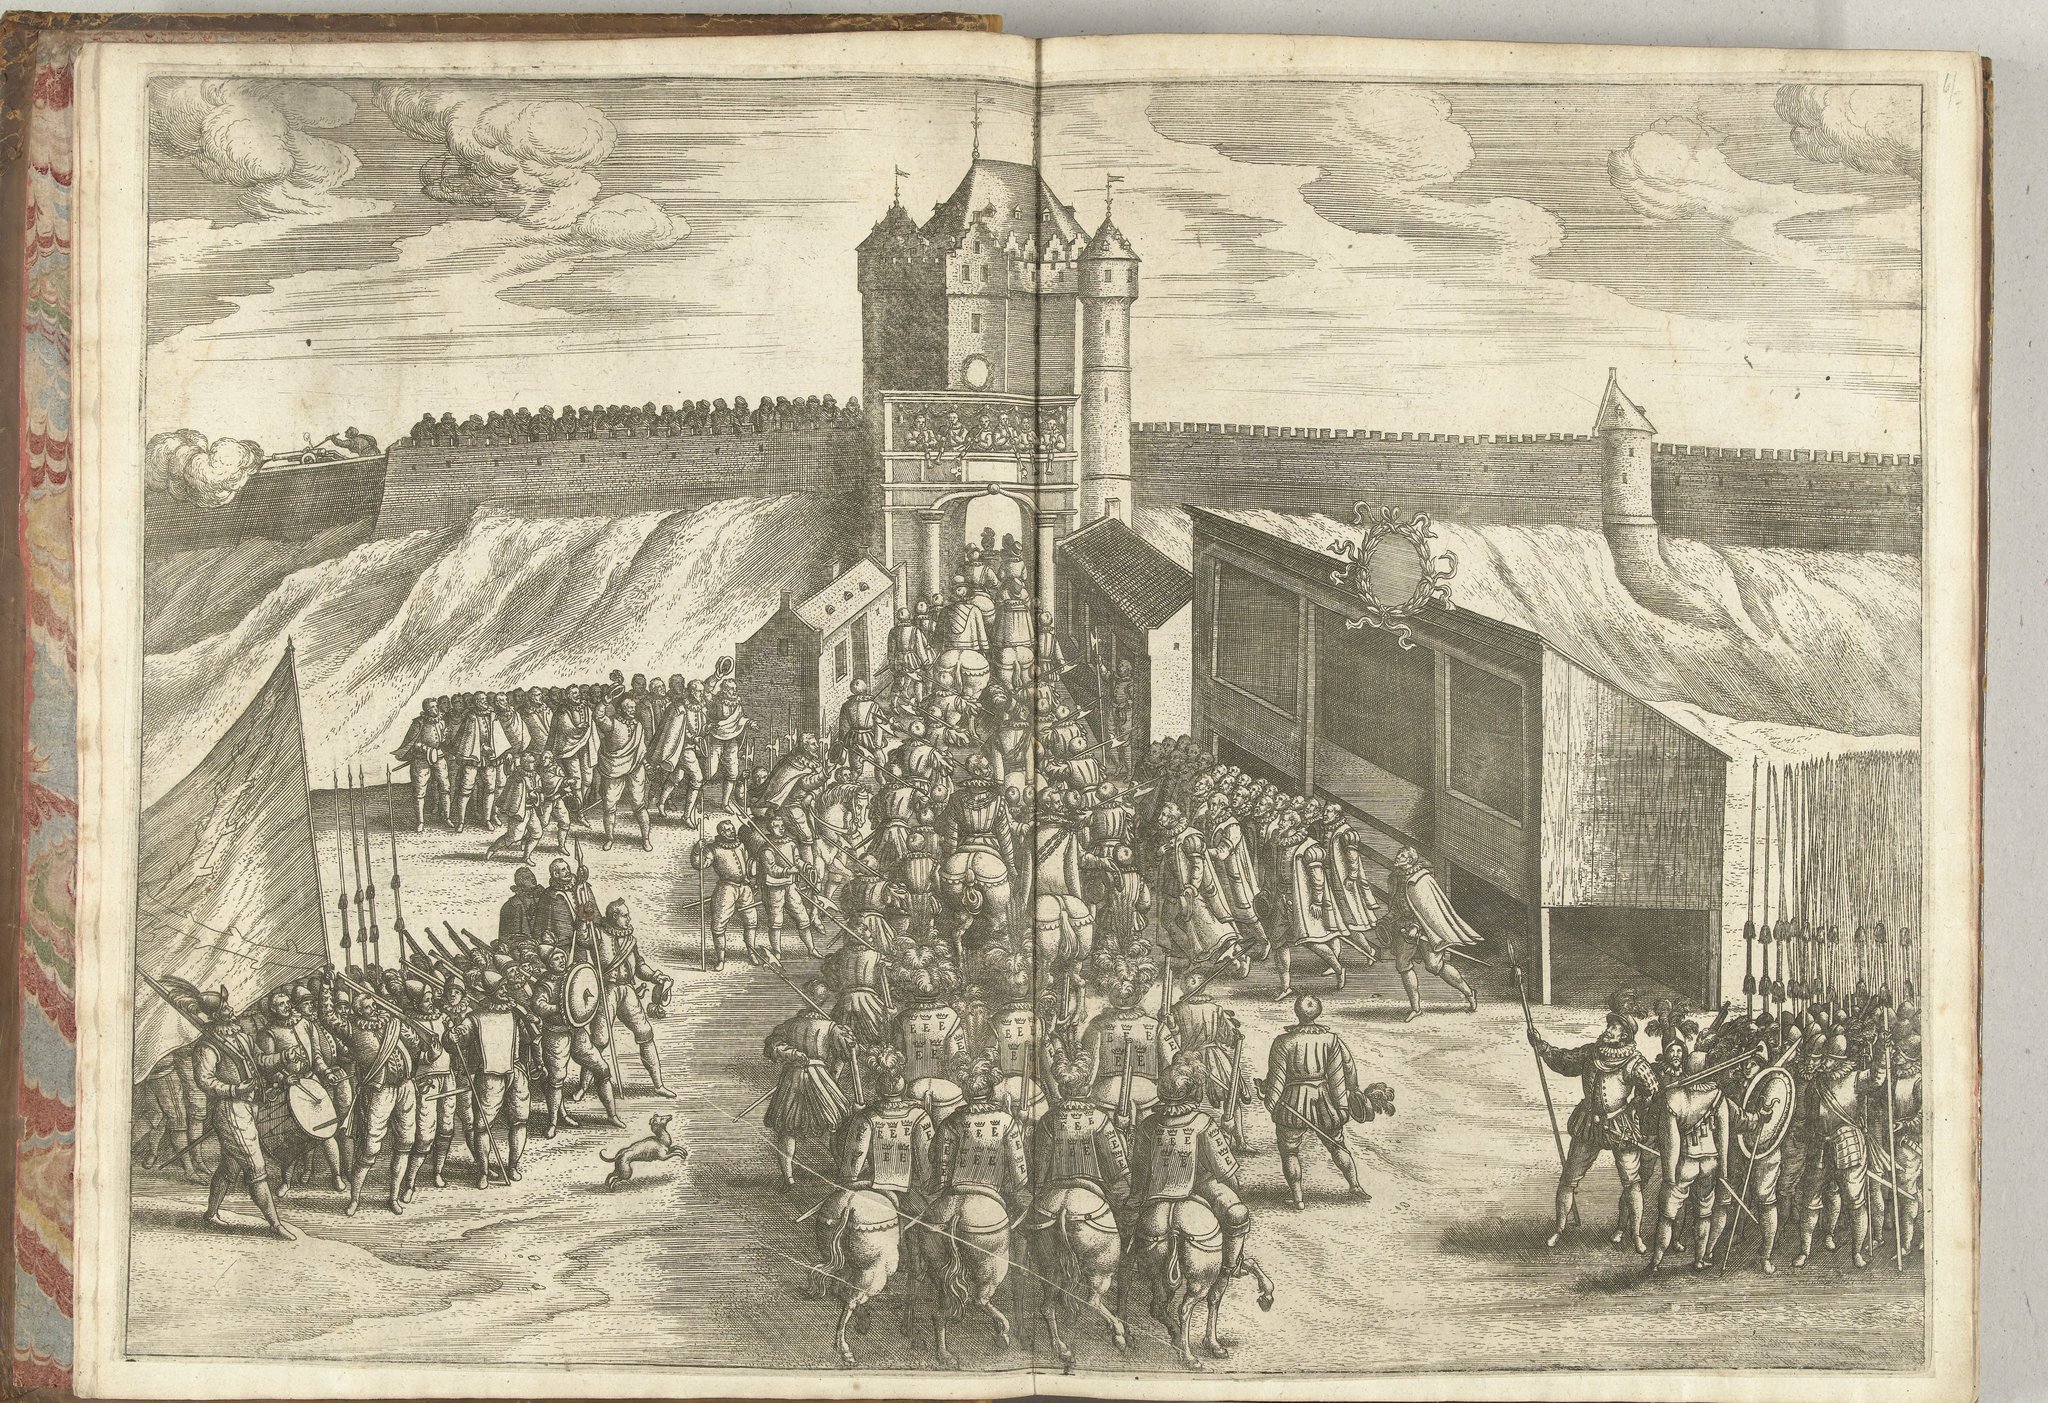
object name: print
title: Intocht van aartshertog Ernst bij een stadspoort van Brussel, 1594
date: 1594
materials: paper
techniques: etching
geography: brussels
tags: vienna, brussels, triumphal entry and public reception, pageant, 'entrée solennelle', 'joyeuse entrée'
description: Aankomst van de stoet met de aartshertog in het midden te paard bij een stadspoort van Brussel. Feestelijke intocht van aartshertog Ernst als gouverneur der Nederlanden gehouden te Brussel op 30 januari 1594. Onderdeel van de beschrijving van deze intocht Descriptio et explicatio pegmatum, arcuum spectaculorum quae Bruxellae Brabant. pridie Cal. Febr. Ao. 1594 exhibita fuere, sub ingressum ... Ernesti ... Archiducis Austriae ... pro Philippo II. Belgicae ditionis gubernatore, J. Mommaert, Brussel 1594. De prent is uitgesneden en opgeplakt in het boek.